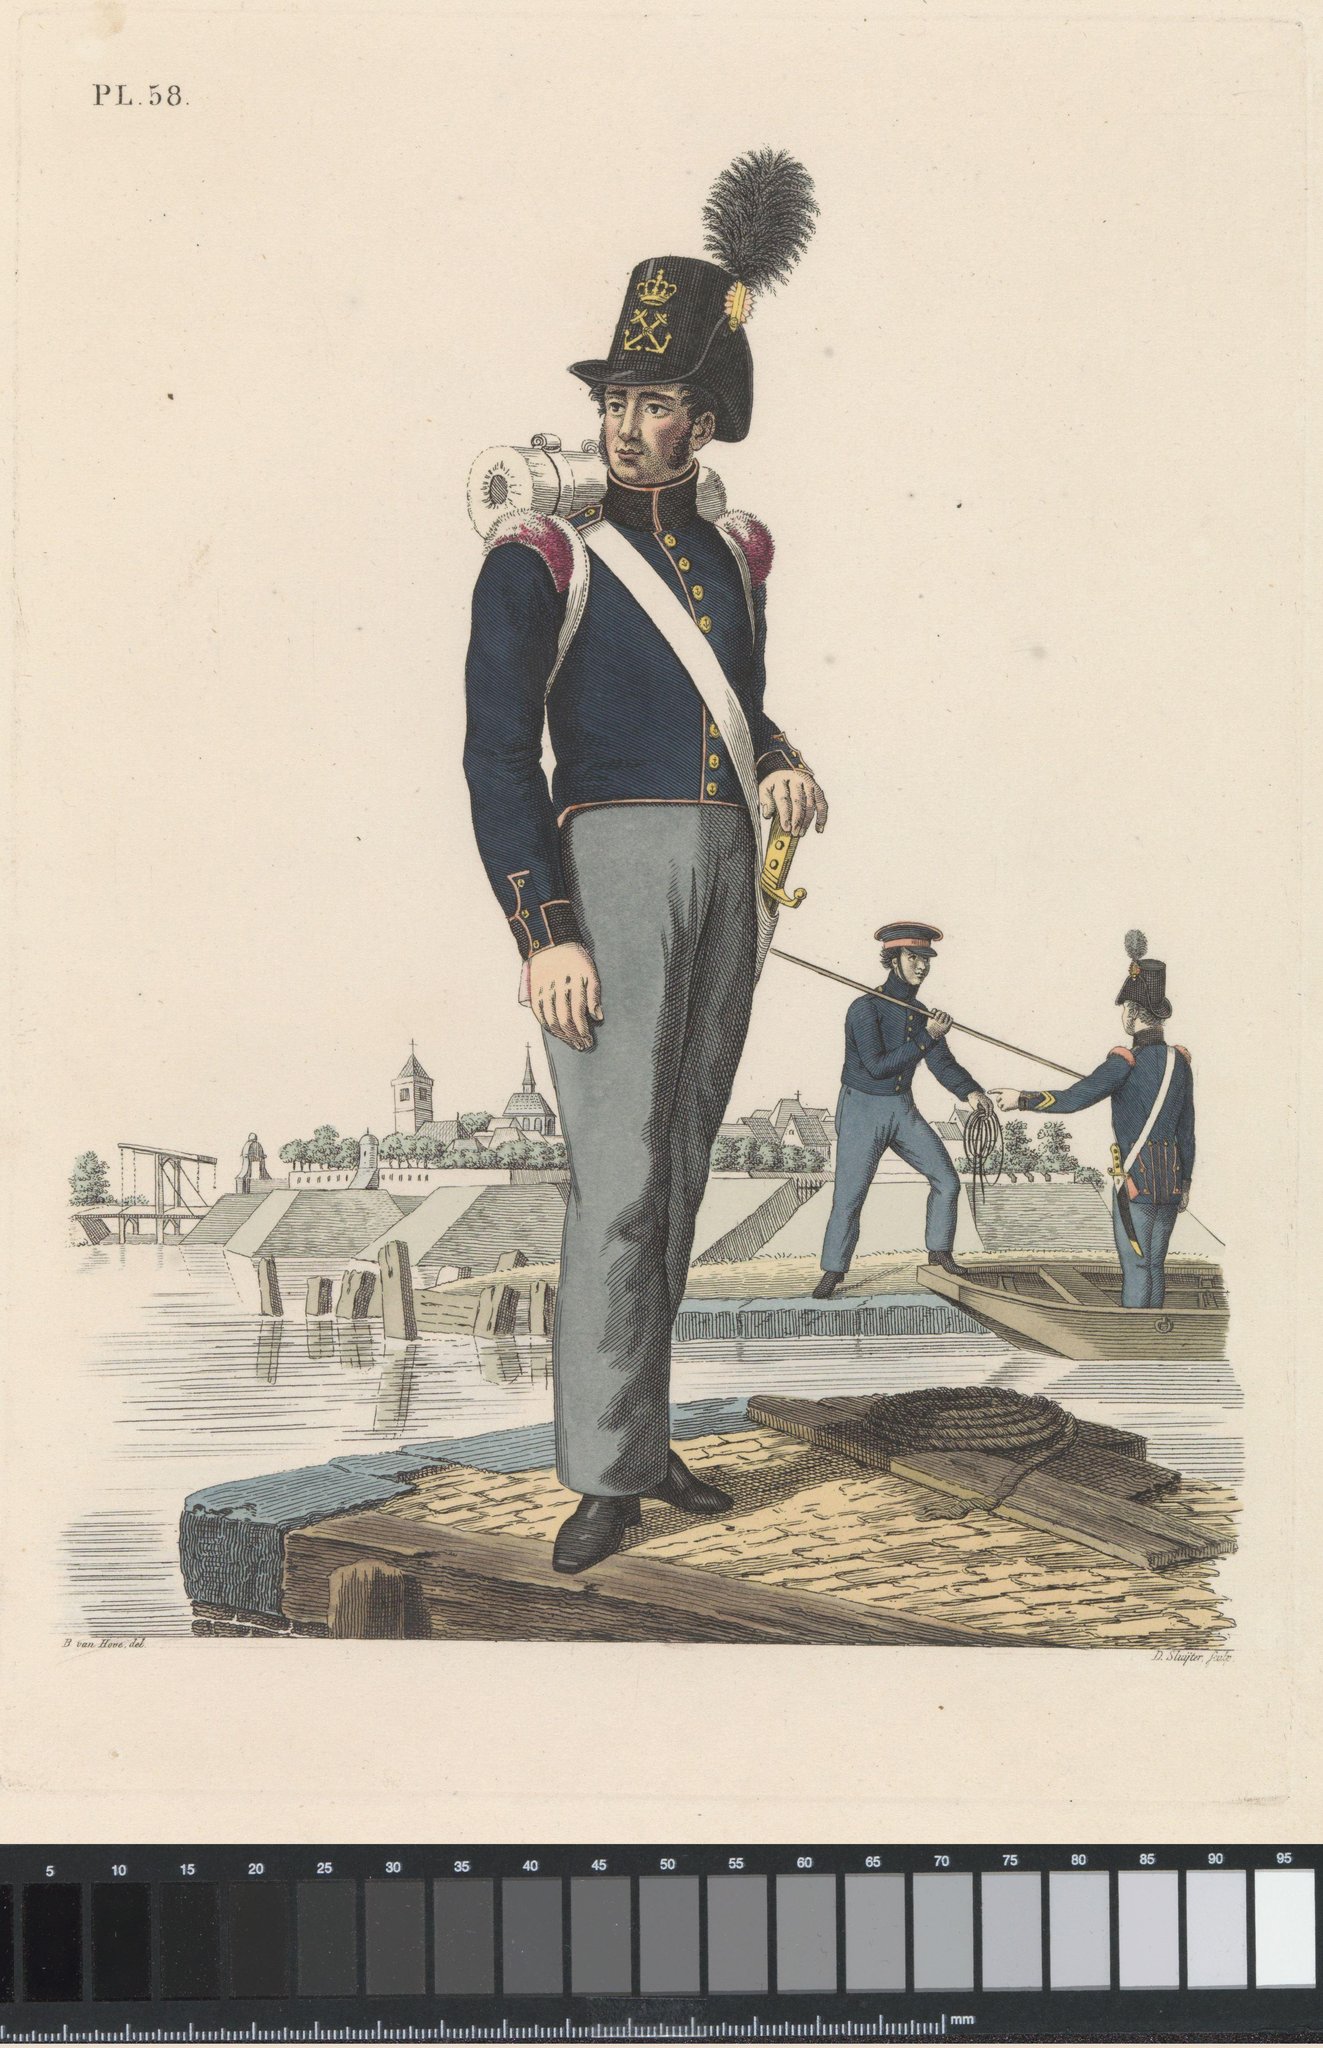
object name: costume print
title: Pontonniers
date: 1826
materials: paper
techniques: engraving, etching, hand coloring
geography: netherlands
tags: (military) uniforms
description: Een Nederlandse pontonnier staande op een kade, op de achtergrond een stad en twee andere militairen waarvan één op een ponton staat. Plaat 58. Uniformvoorstelling in 'Vervolg van de Beschrijving hoedanig de Koninklijke Nederlandsche troepen' van J.F. Teupken, 1826.